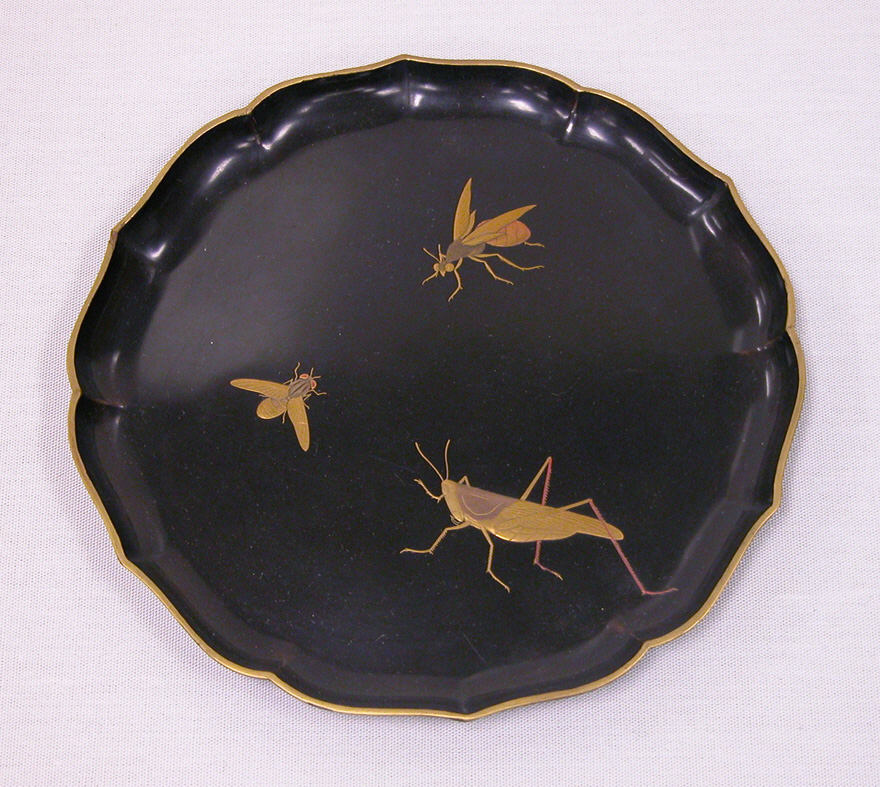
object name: tray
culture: japanese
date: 1801-1900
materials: gold, lacquer, silver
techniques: hiramakie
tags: insects